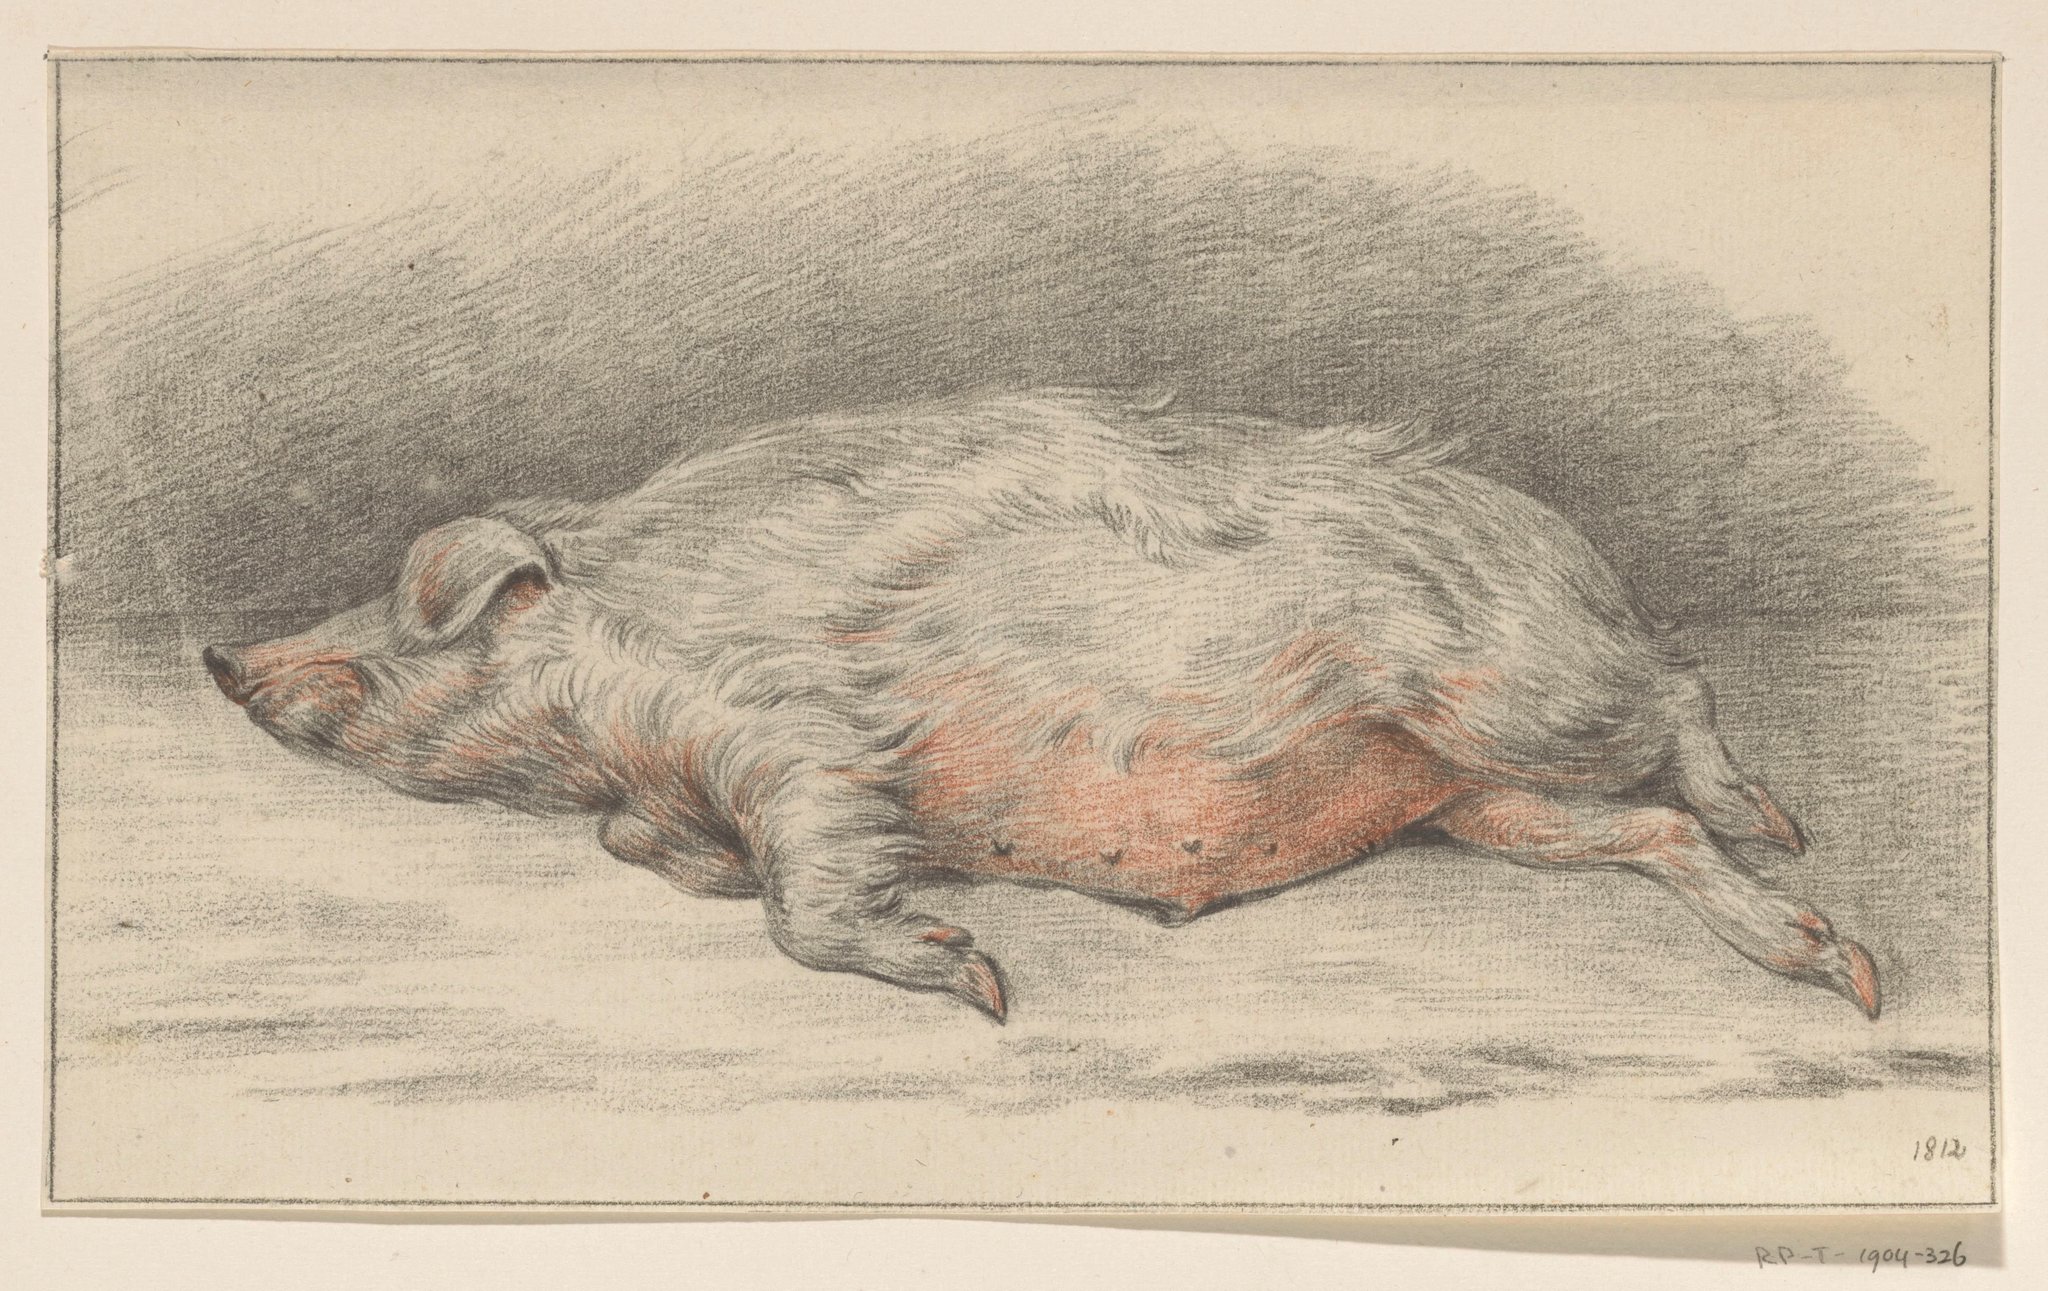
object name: drawing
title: Liggend varken, naar links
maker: jean bernard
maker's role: draughtsman, print maker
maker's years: 1765-1833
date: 1812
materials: chalk, paper, pencil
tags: pig